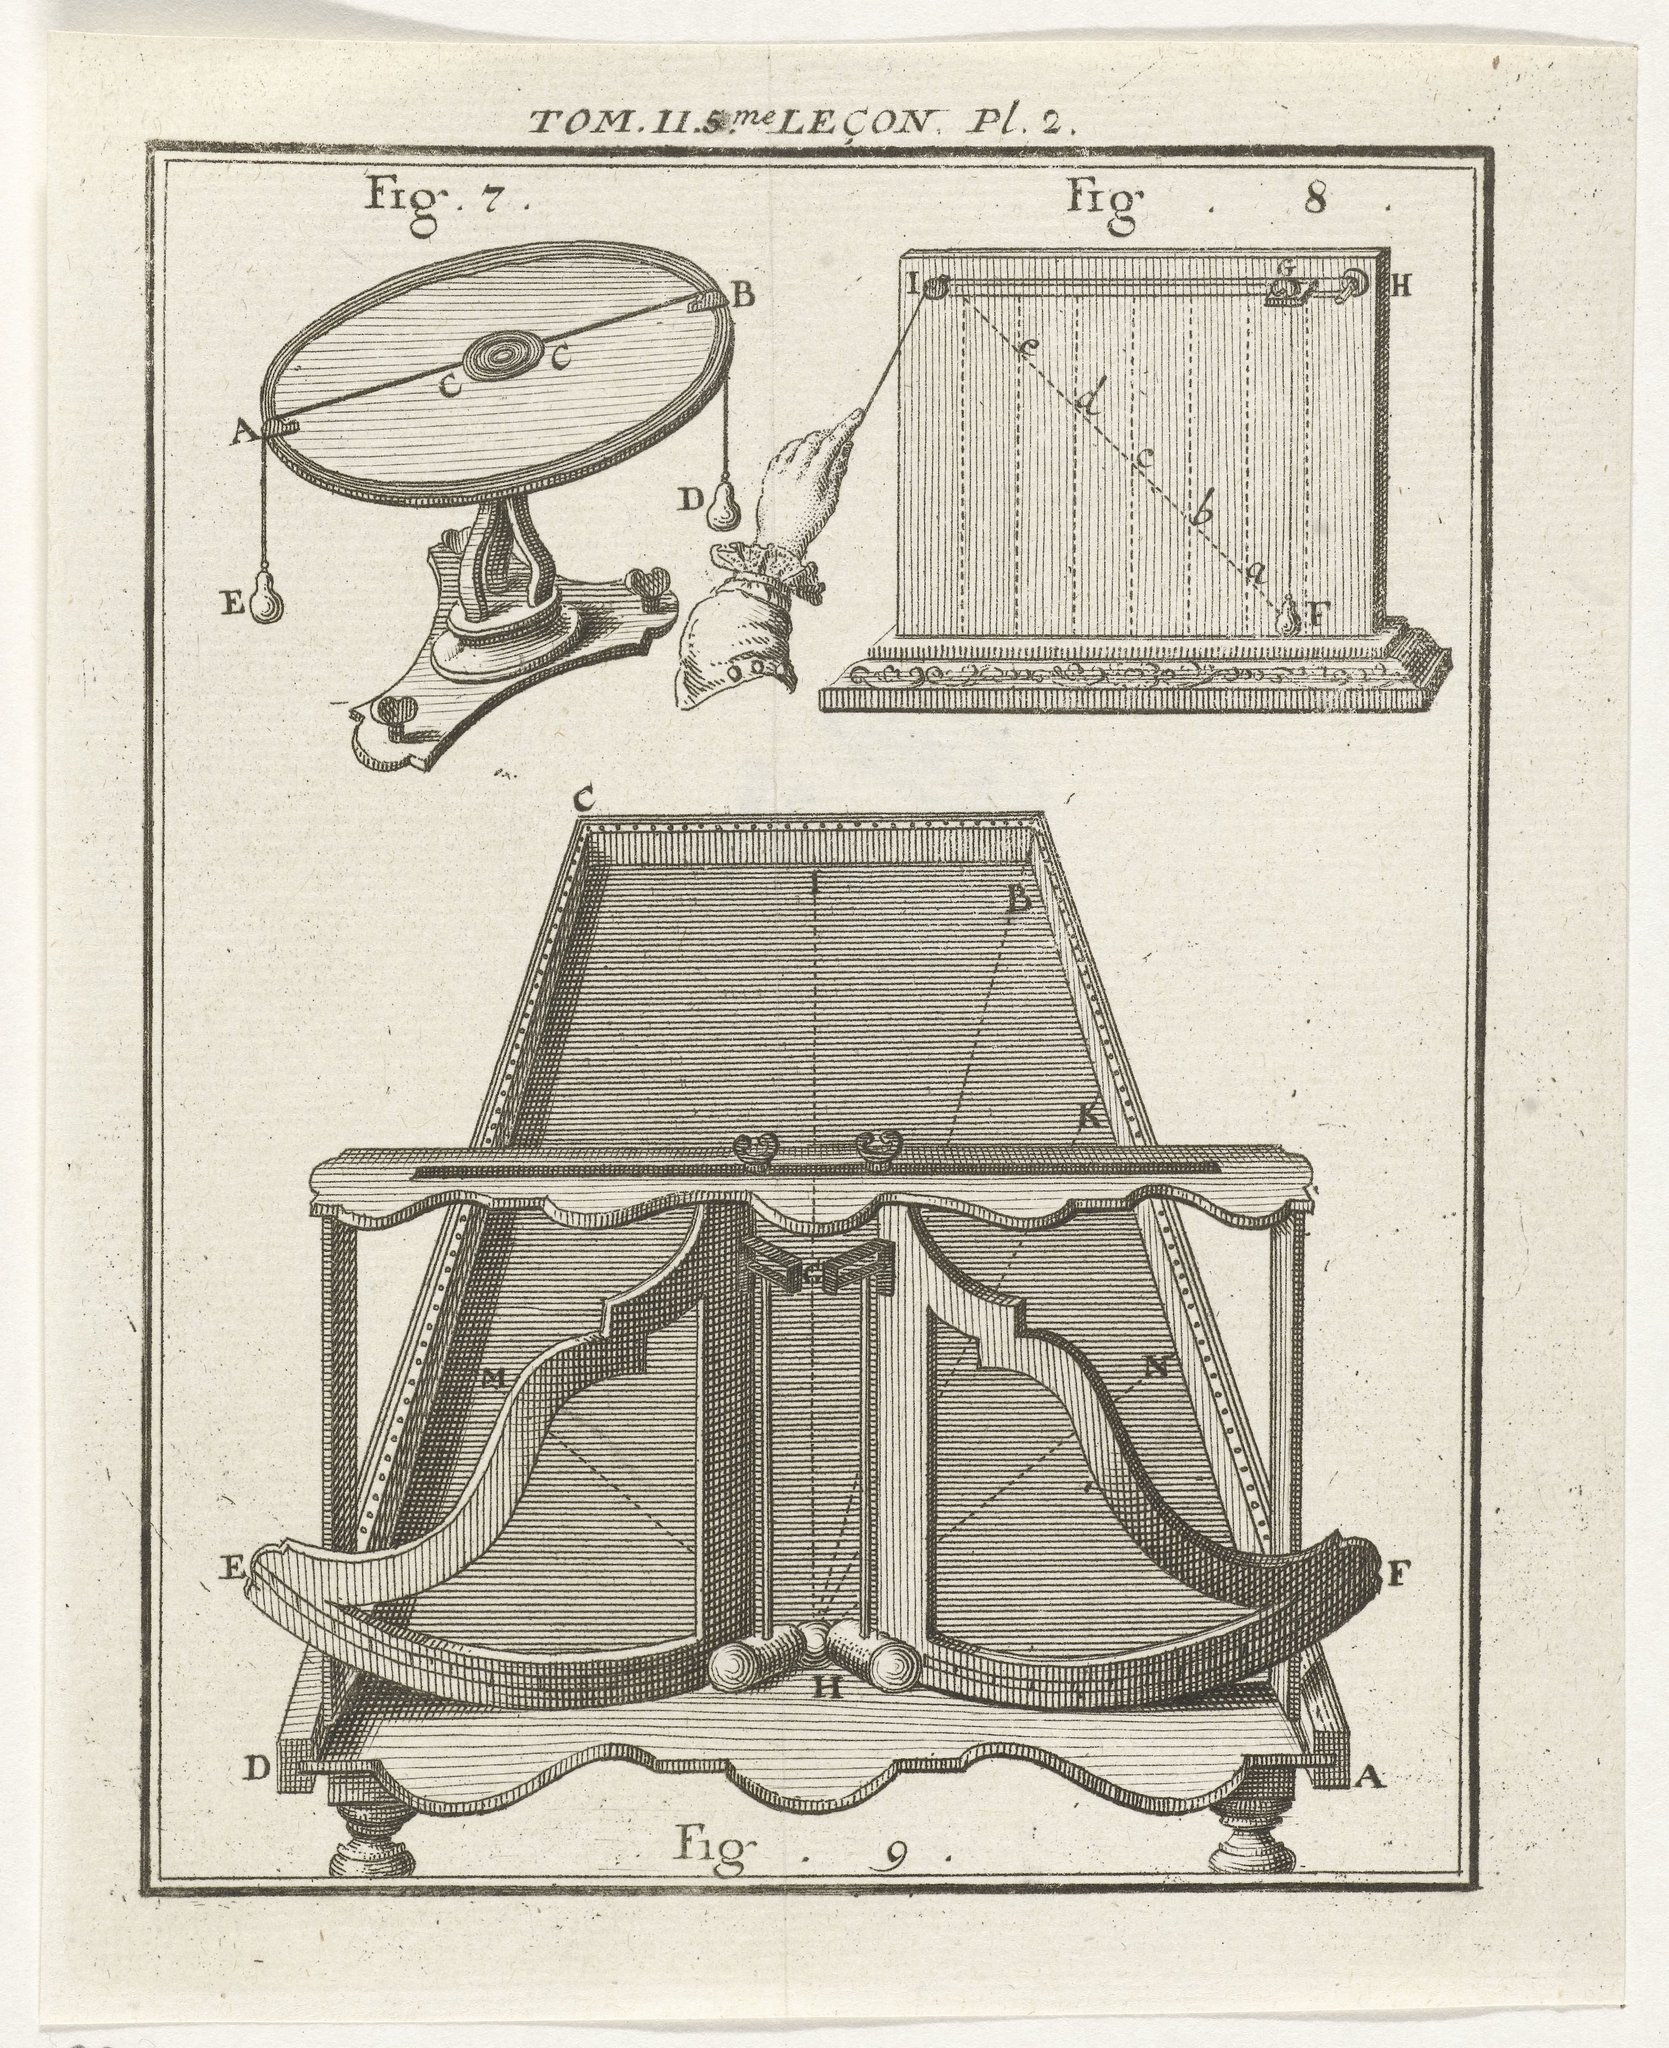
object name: book illustration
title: Voorwerpen voor natuurkundig onderzoek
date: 1759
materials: paper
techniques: etching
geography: amsterdam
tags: physics (+ tools, instruments; laboratory equipment ~ scientific research)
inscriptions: collector's mark: Lugt 2228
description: Illustratie voor: Nollet, Jean Antoine. Natuurkundige lessen, door proefneemingen bevestigd, eerste deel. Amsterdam: Kornelis van Tongerlo, 1759.